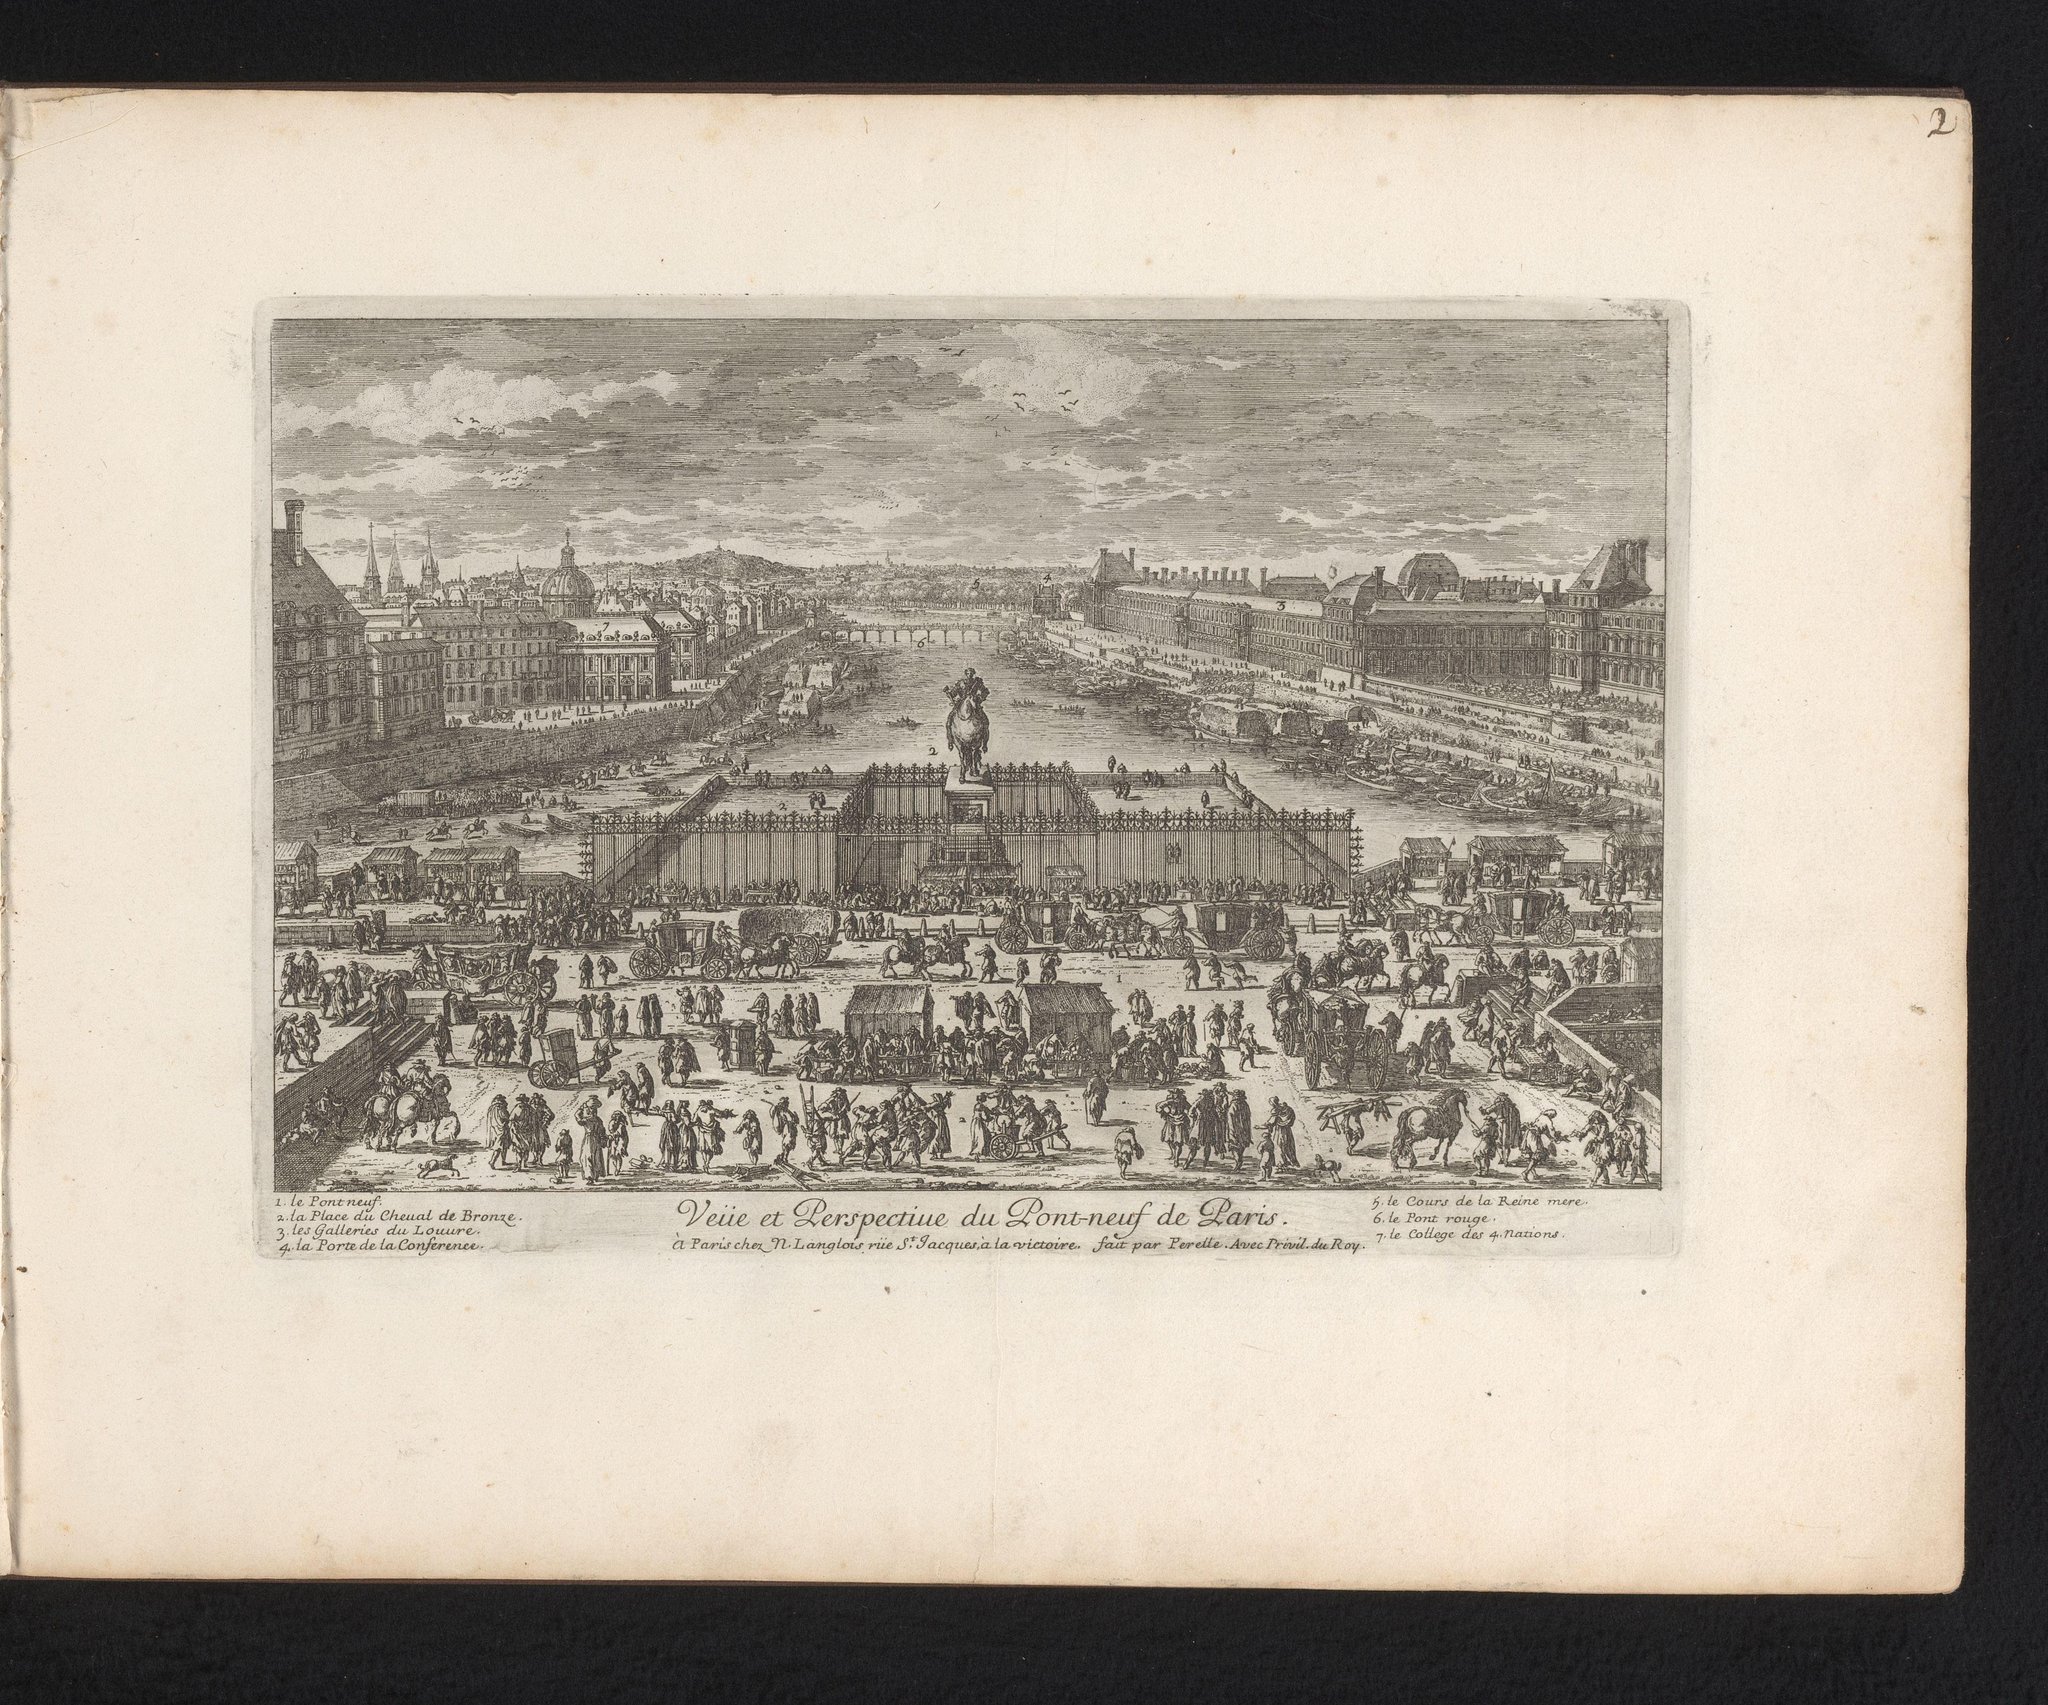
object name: album leaf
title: Veüe et perspective du Pont-neuf de Paris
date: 1660-1703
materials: paper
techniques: etching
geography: paris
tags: monument, statue, equestrian statue, bridge in city across river, canal, etc.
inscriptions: collector's mark: Lugt 2228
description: Prenten met het signatuur 'Perelle' kunnen zowel door vader Gabriel als door zonen Nicolas en Adam gemaakt zijn. De uitgevers vader en zoon Nicolas Langlois worden allebei vermeld als N. Langlois op hetzelfde adres.